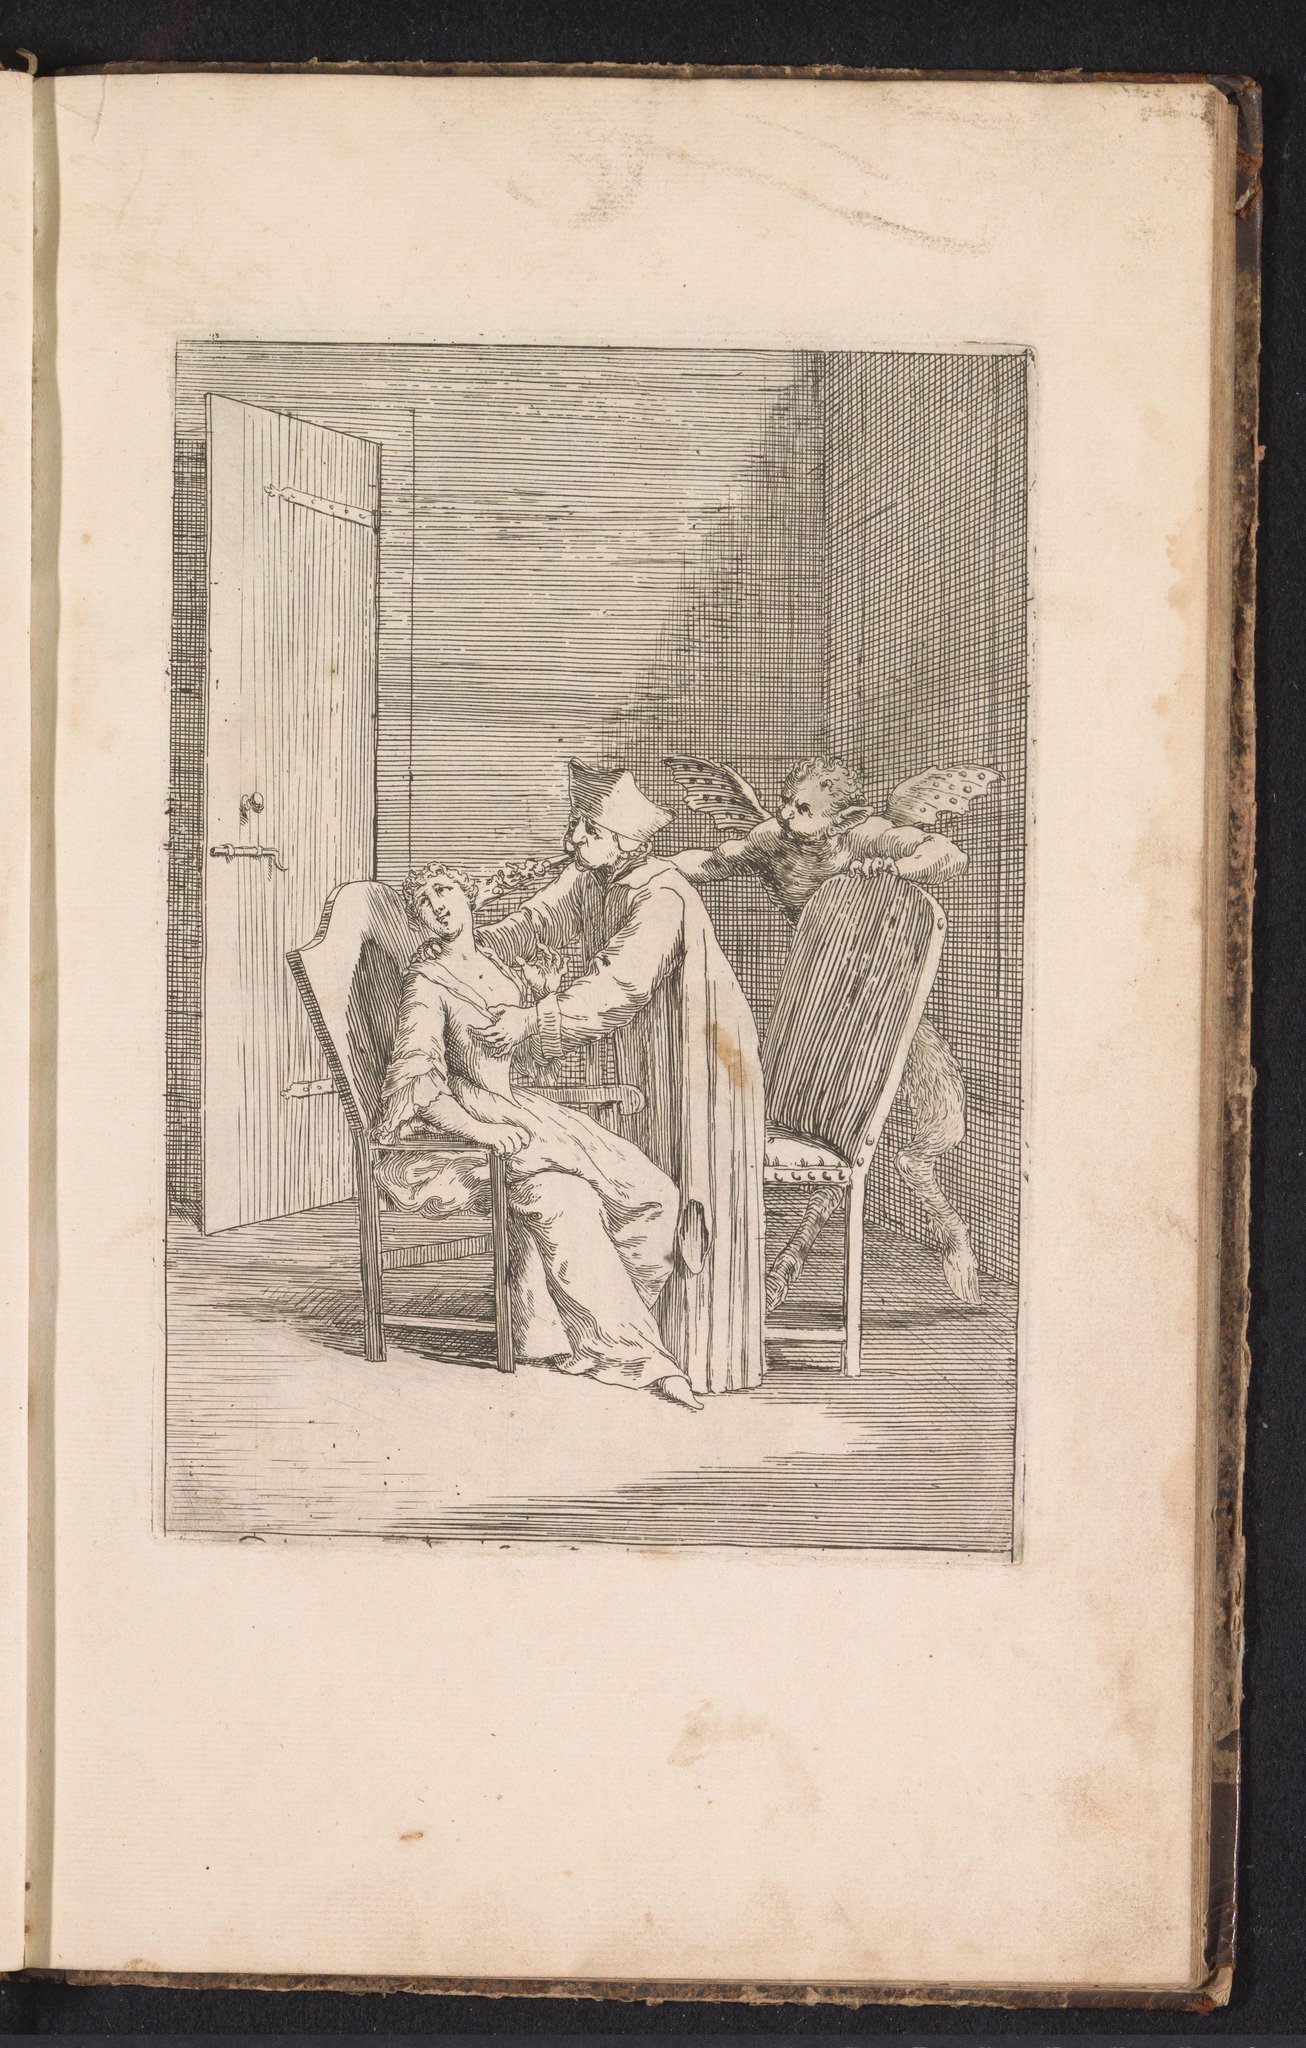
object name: print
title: Tableaux De l'Histoire Du Pere Jean Baptiste Girard & Marie Catherine Cadiere en XXXII Estampes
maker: jacques gabriel huquier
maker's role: draughtsman, painter, print maker, publisher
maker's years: 1725-1805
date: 1735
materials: paper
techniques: etching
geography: france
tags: witch, sorcerer with the devil and/or demons, sexual abuses of monks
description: Jean-Baptiste Girard blaast Marie-Catherine Cadière meer giftige adem in en maakt haar kleding los. Onderdeel van de reeks van 32, veelal erotisch getinte, prenten gewijd aan het schandaal rond Marie-Catherine Cadière en de Jezuïet Jean-Baptiste Girard in 1730-1731.